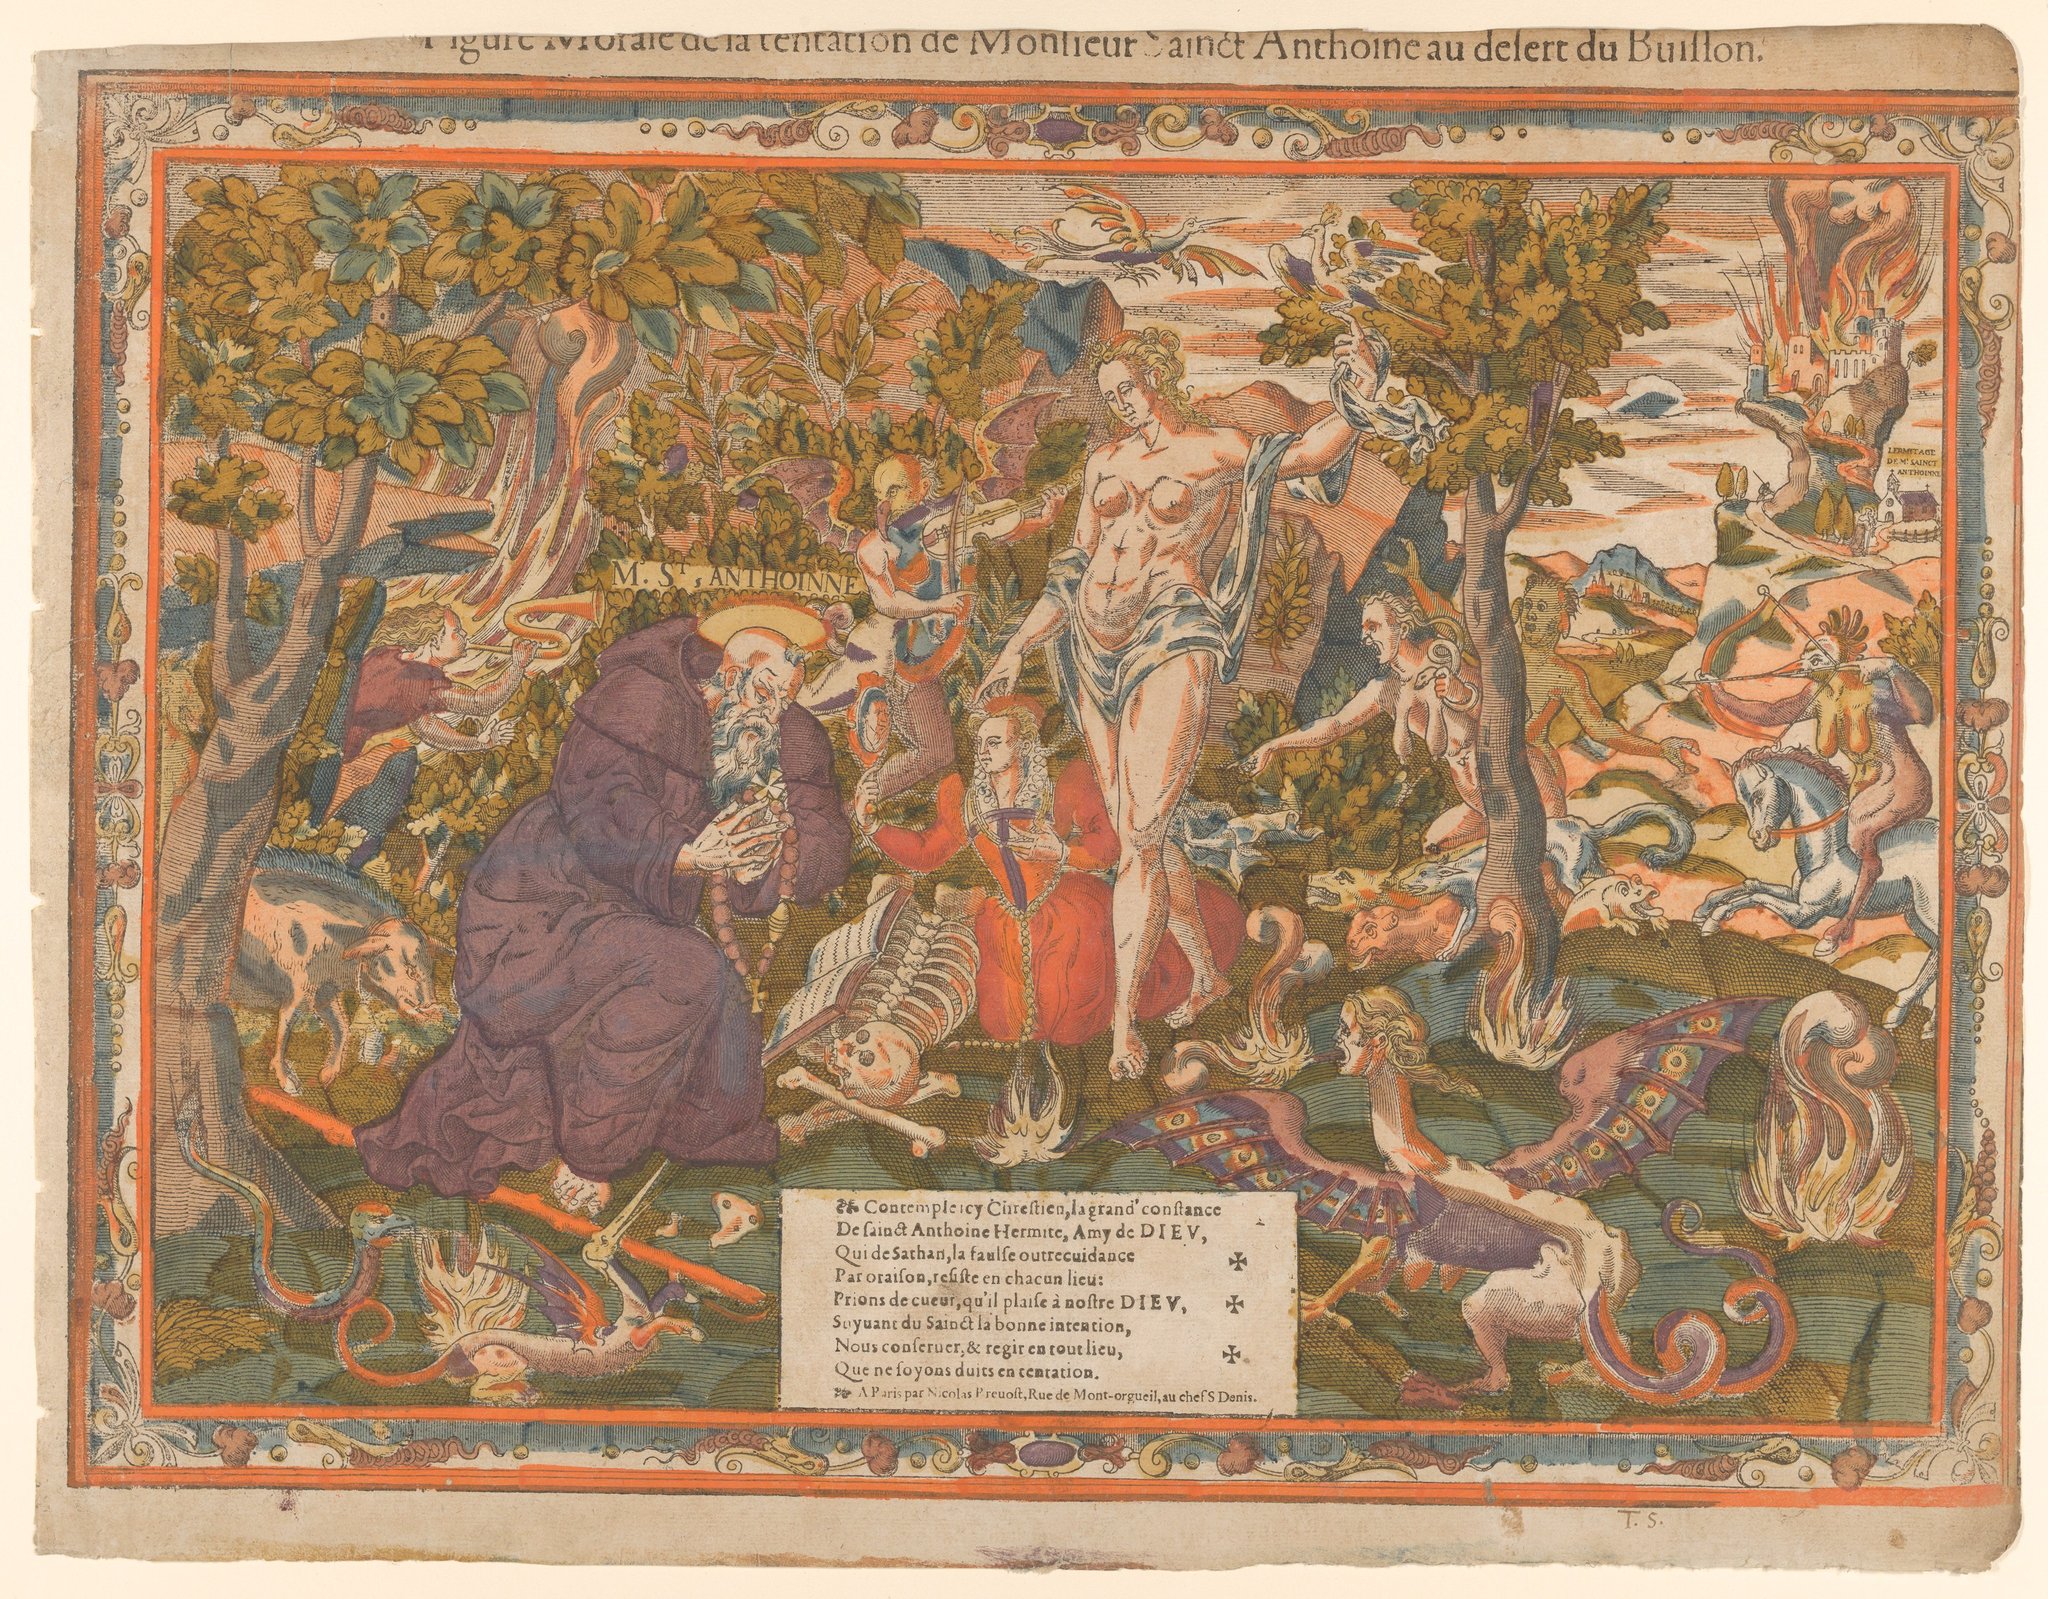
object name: print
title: The Temptation of St. Anthony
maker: anonymous, french, 16th century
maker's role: artist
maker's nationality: french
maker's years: 1500-1600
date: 1560-1580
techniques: hand coloring, woodcut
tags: skulls,female nudes,saint anthony